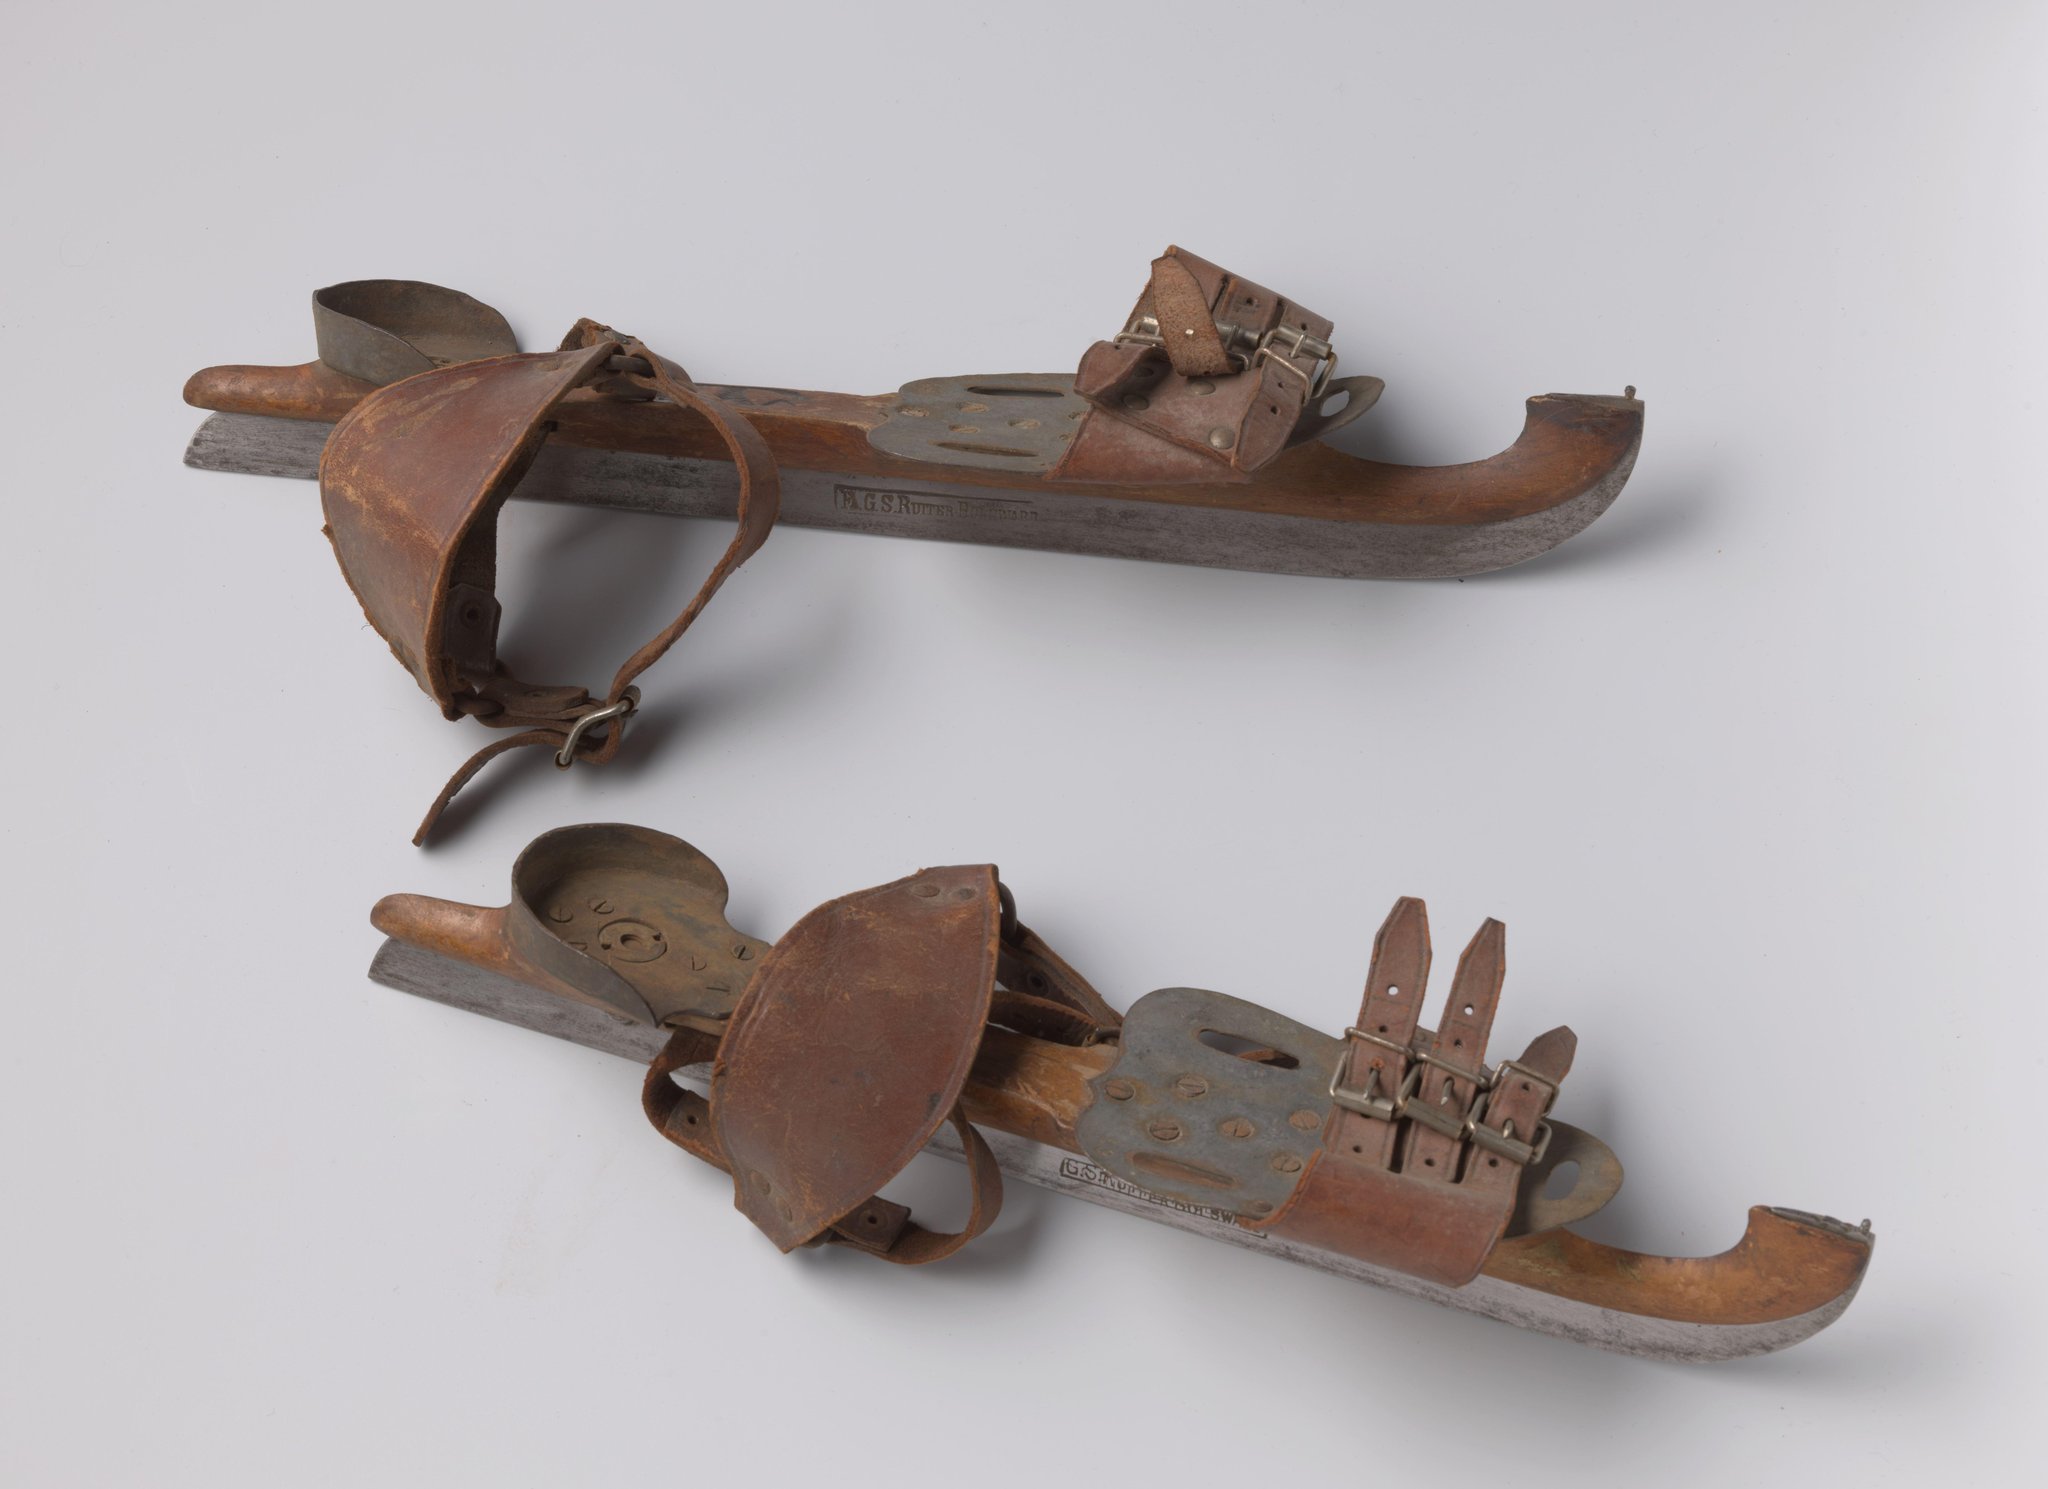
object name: skate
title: Vissering-Ruiter of Koninginneschaats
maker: gerard vissering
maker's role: designer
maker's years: 1865-1937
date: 1891-1955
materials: copper, iron, leather, wood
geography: friesland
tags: the hague, print maker, wilhelmina of the netherlands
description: De firma Ruiter leverde een vergelijkbare schaats in 1895 'op order' aan koningin-moeder Emma. Prinses Wilhelmina reed er graag op. Nadat Wilhelmina in 1898 koningin werd en zij dit model in 1899 en 1900 opnieuwe bestelde bij Ruiter kreeg de schaat de naam Koninginneschaats. Overigens wenste de koningin dat de schaatsen voorzien zouden zijn van geelkoperen voetplaten en niet van roodkoper zoals Ruiter bedoeld had.